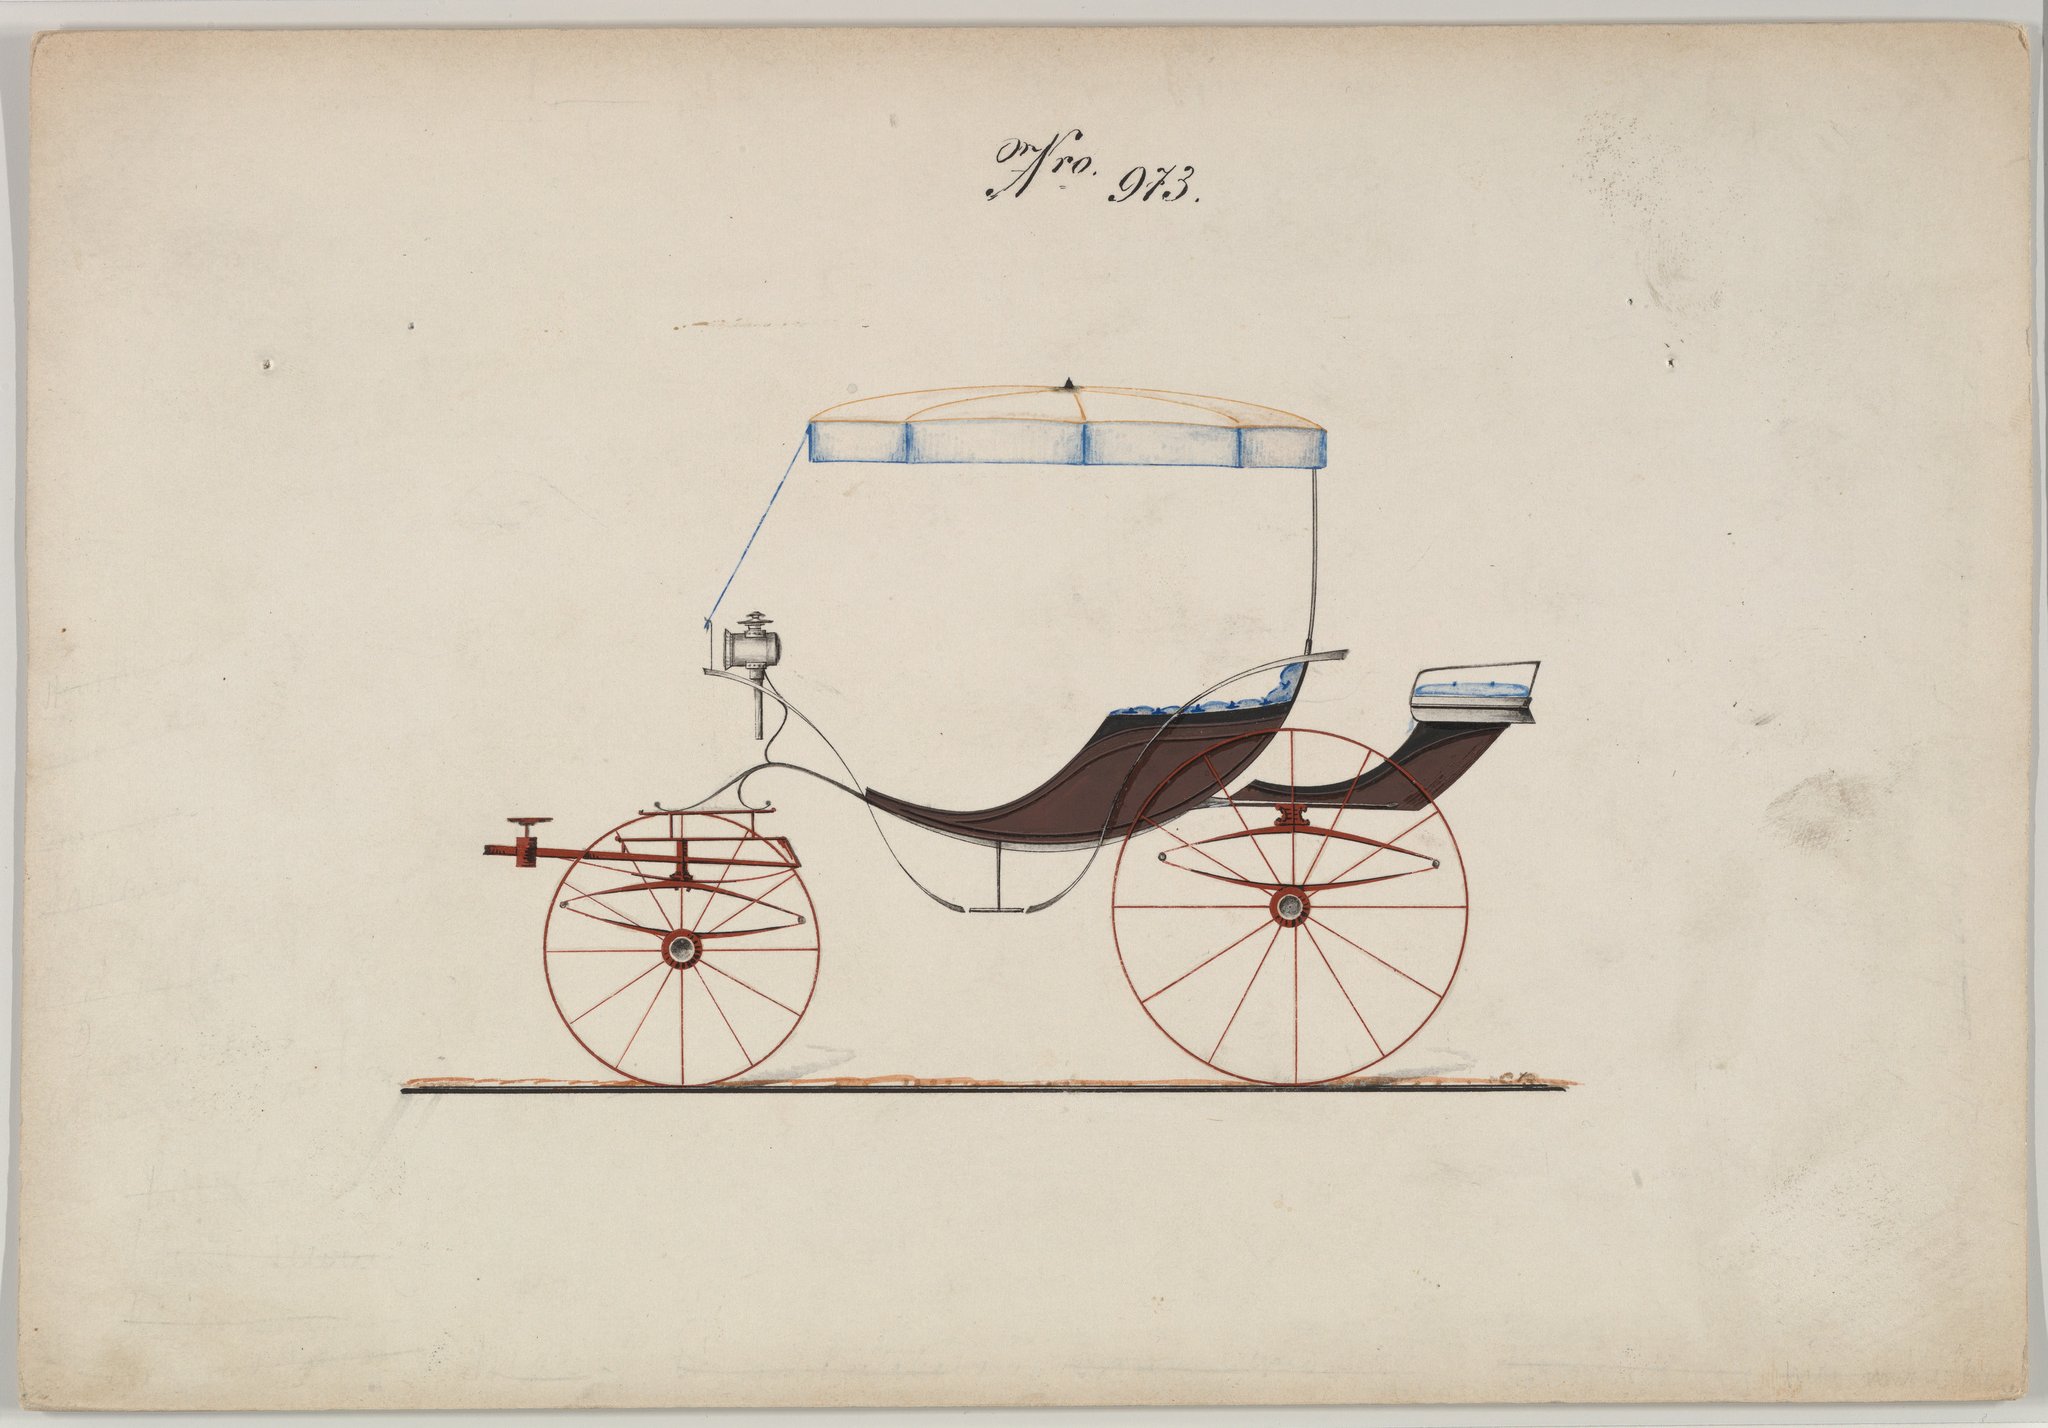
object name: drawing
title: Parasol Top Phaeton #973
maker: brewster & co.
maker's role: manufacturer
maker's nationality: american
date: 1870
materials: gouache, gum arabic, ink, watercolor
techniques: pen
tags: carriages